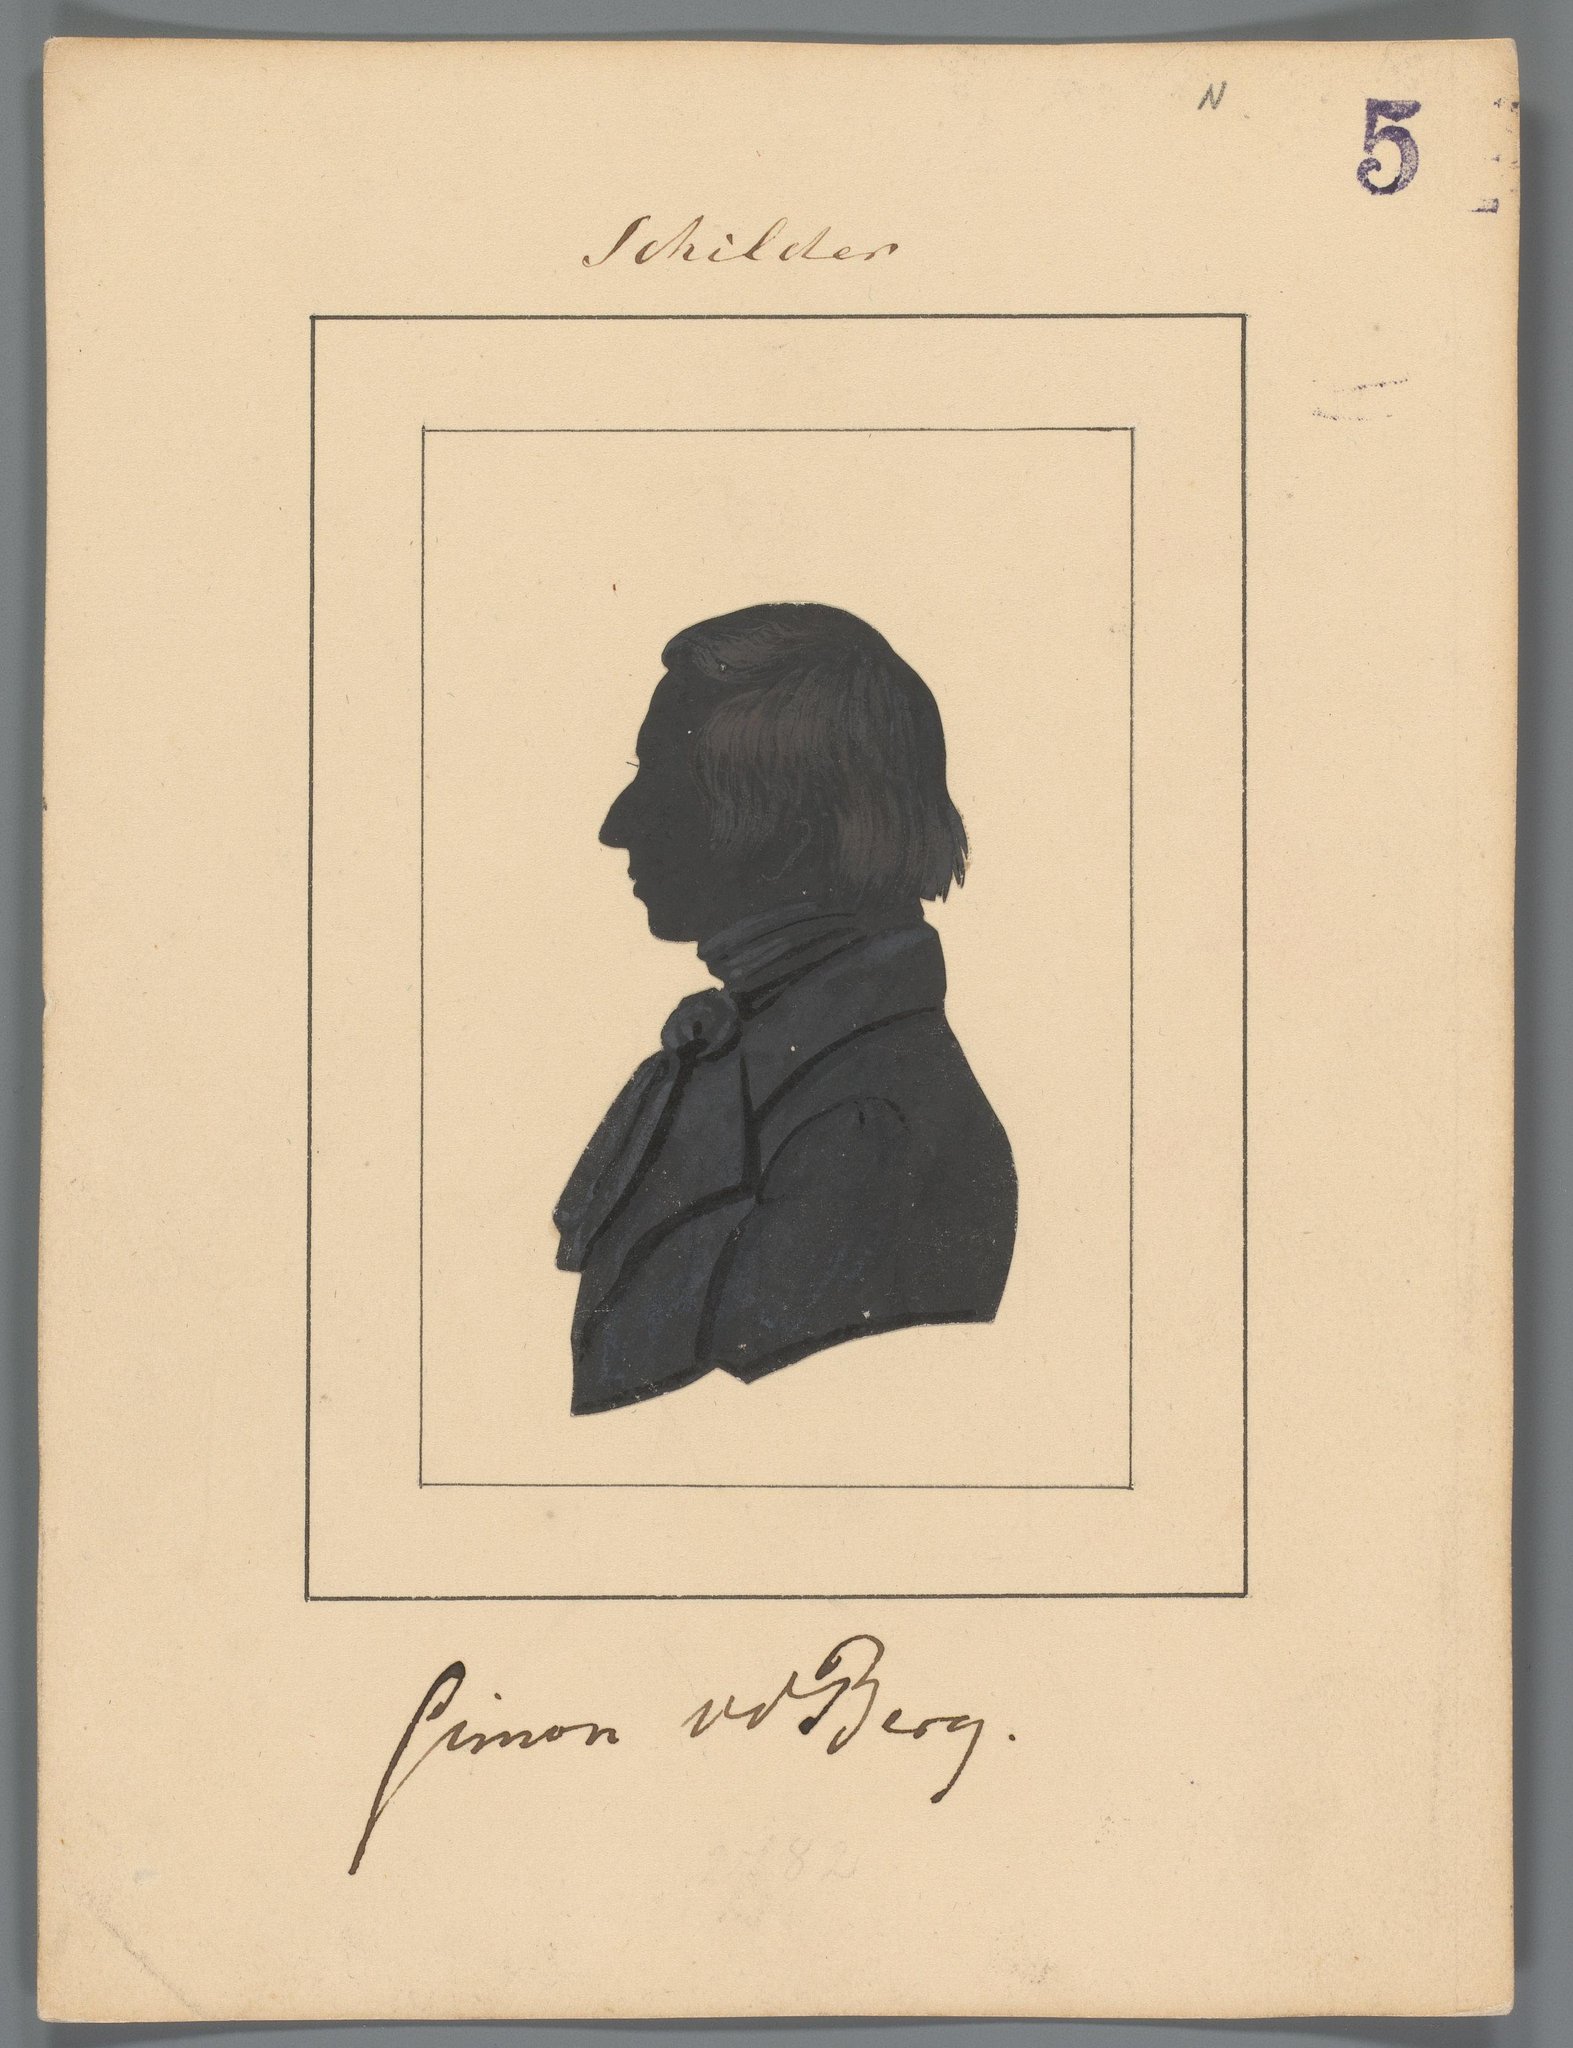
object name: cut paper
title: Silhouetportret van Simon van den Berg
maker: elisabeth alida haanen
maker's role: draughtsman, print maker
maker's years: 1809-1845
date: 1819-1845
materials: ink, paint, paper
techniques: brush, snipping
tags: arnhem, simon van den berg, historical persons, portrait, self-portrait of painter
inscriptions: collector's mark: ‘Ex-libris van Beresteyn’, inscription: ‘D. 1348’, number: ‘13994’, number: ‘5’, inscription: ‘Schilder’, inscription: ‘Simon vd Berg’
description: Met onder het portret de handtekening van de geportretteerde.